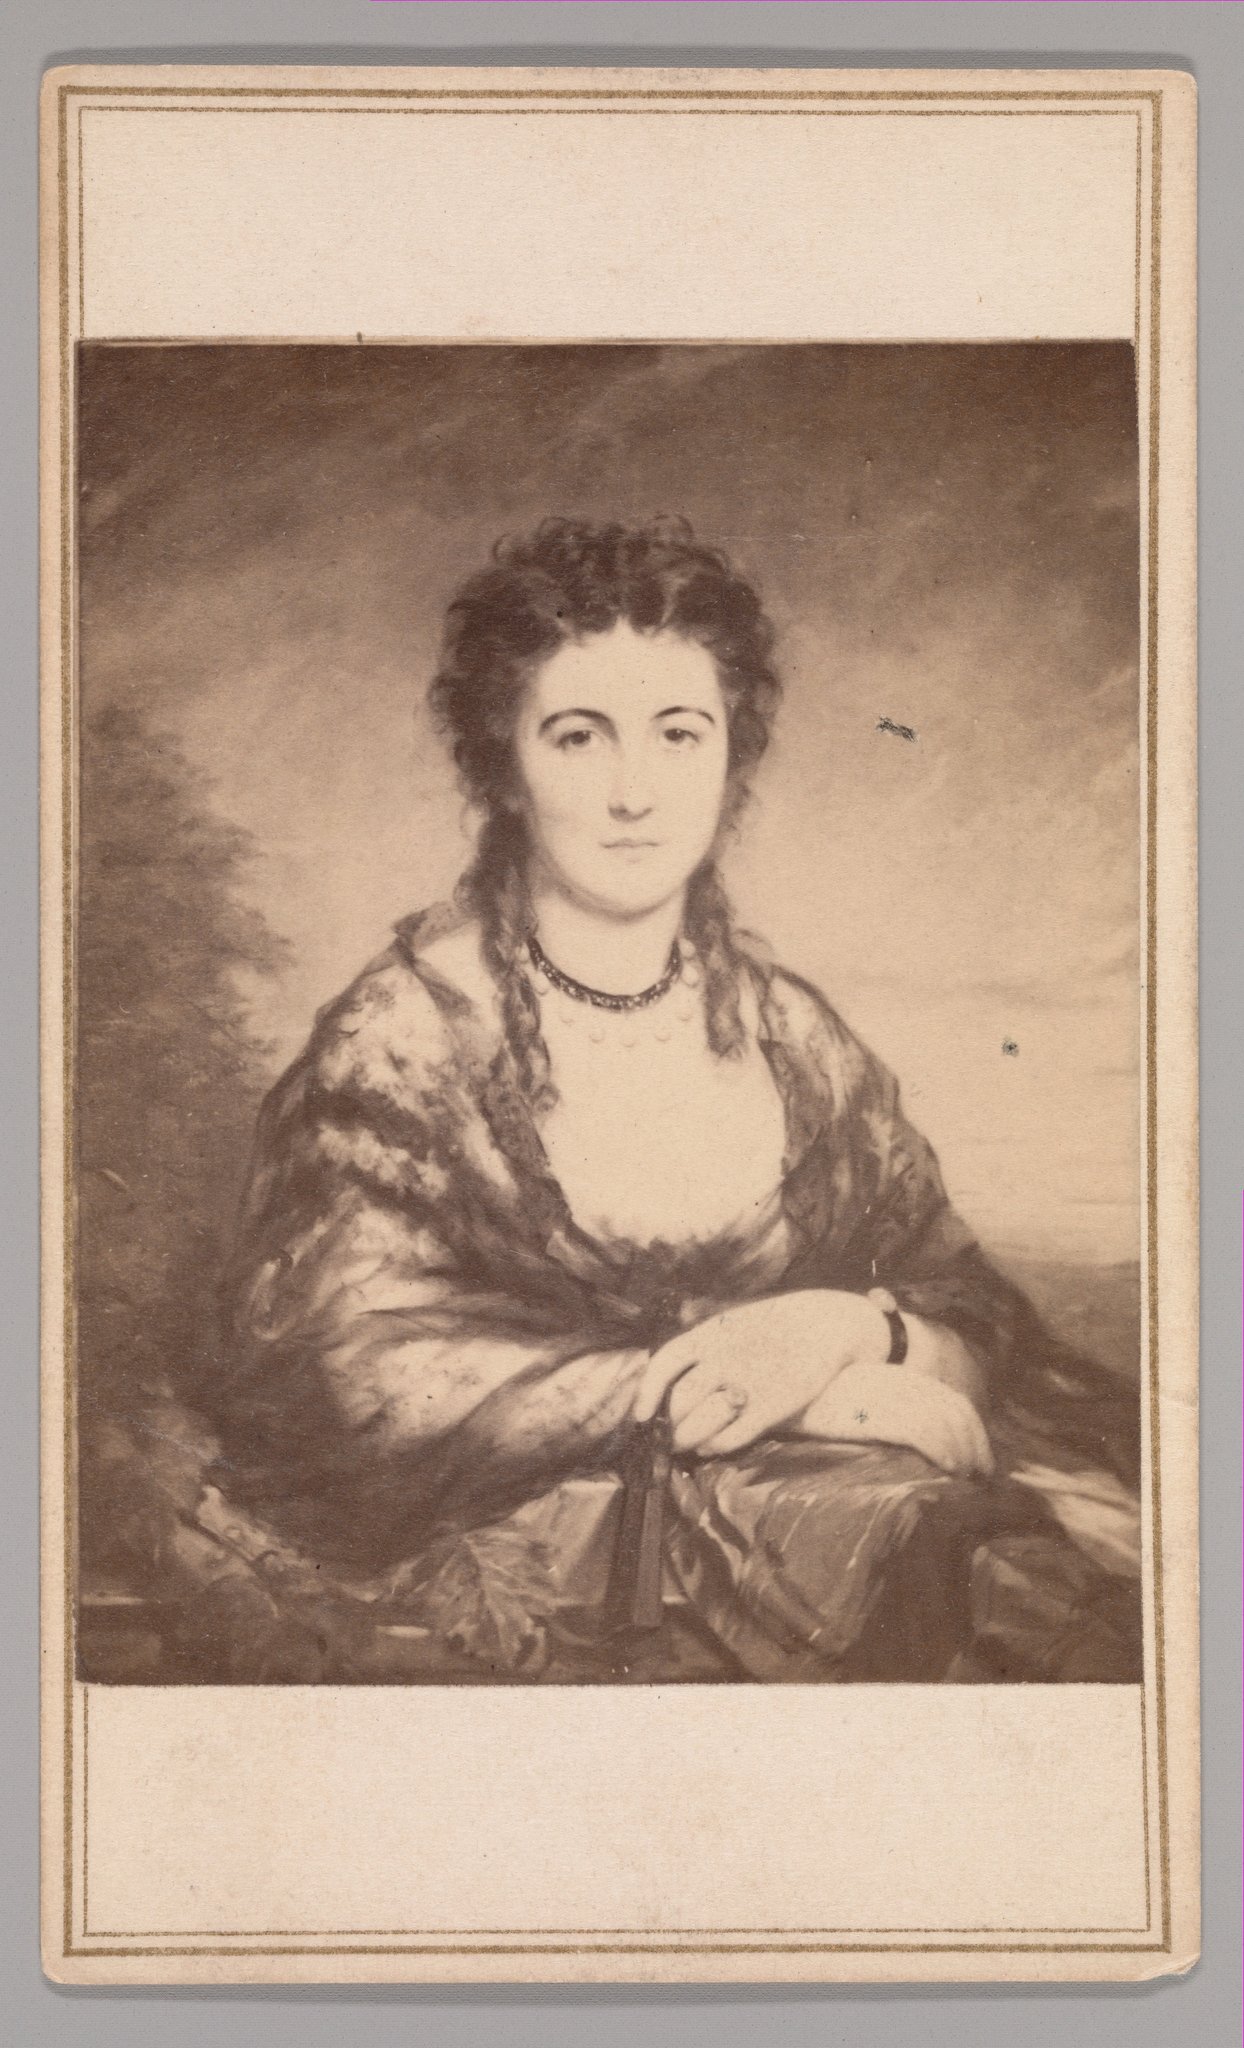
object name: carte de visite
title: [Unknown Subject]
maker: Anonymous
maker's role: artist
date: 1860-1869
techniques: albumen silver print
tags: portraits,women